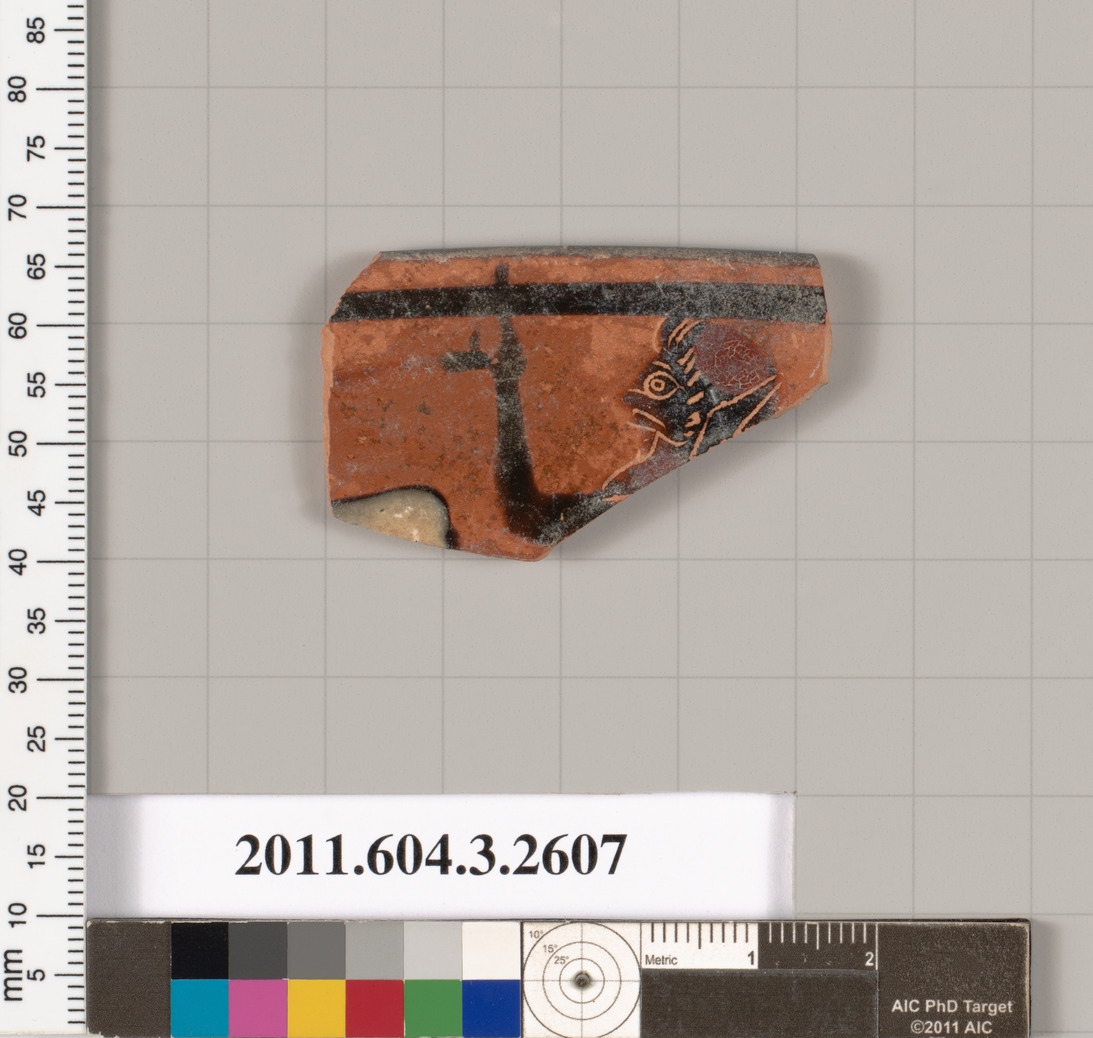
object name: kylix fragment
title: Terracotta rim fragment of a kylix: eye-cup (drinking cup)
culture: greek, attic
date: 525-501 BCE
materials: terracotta